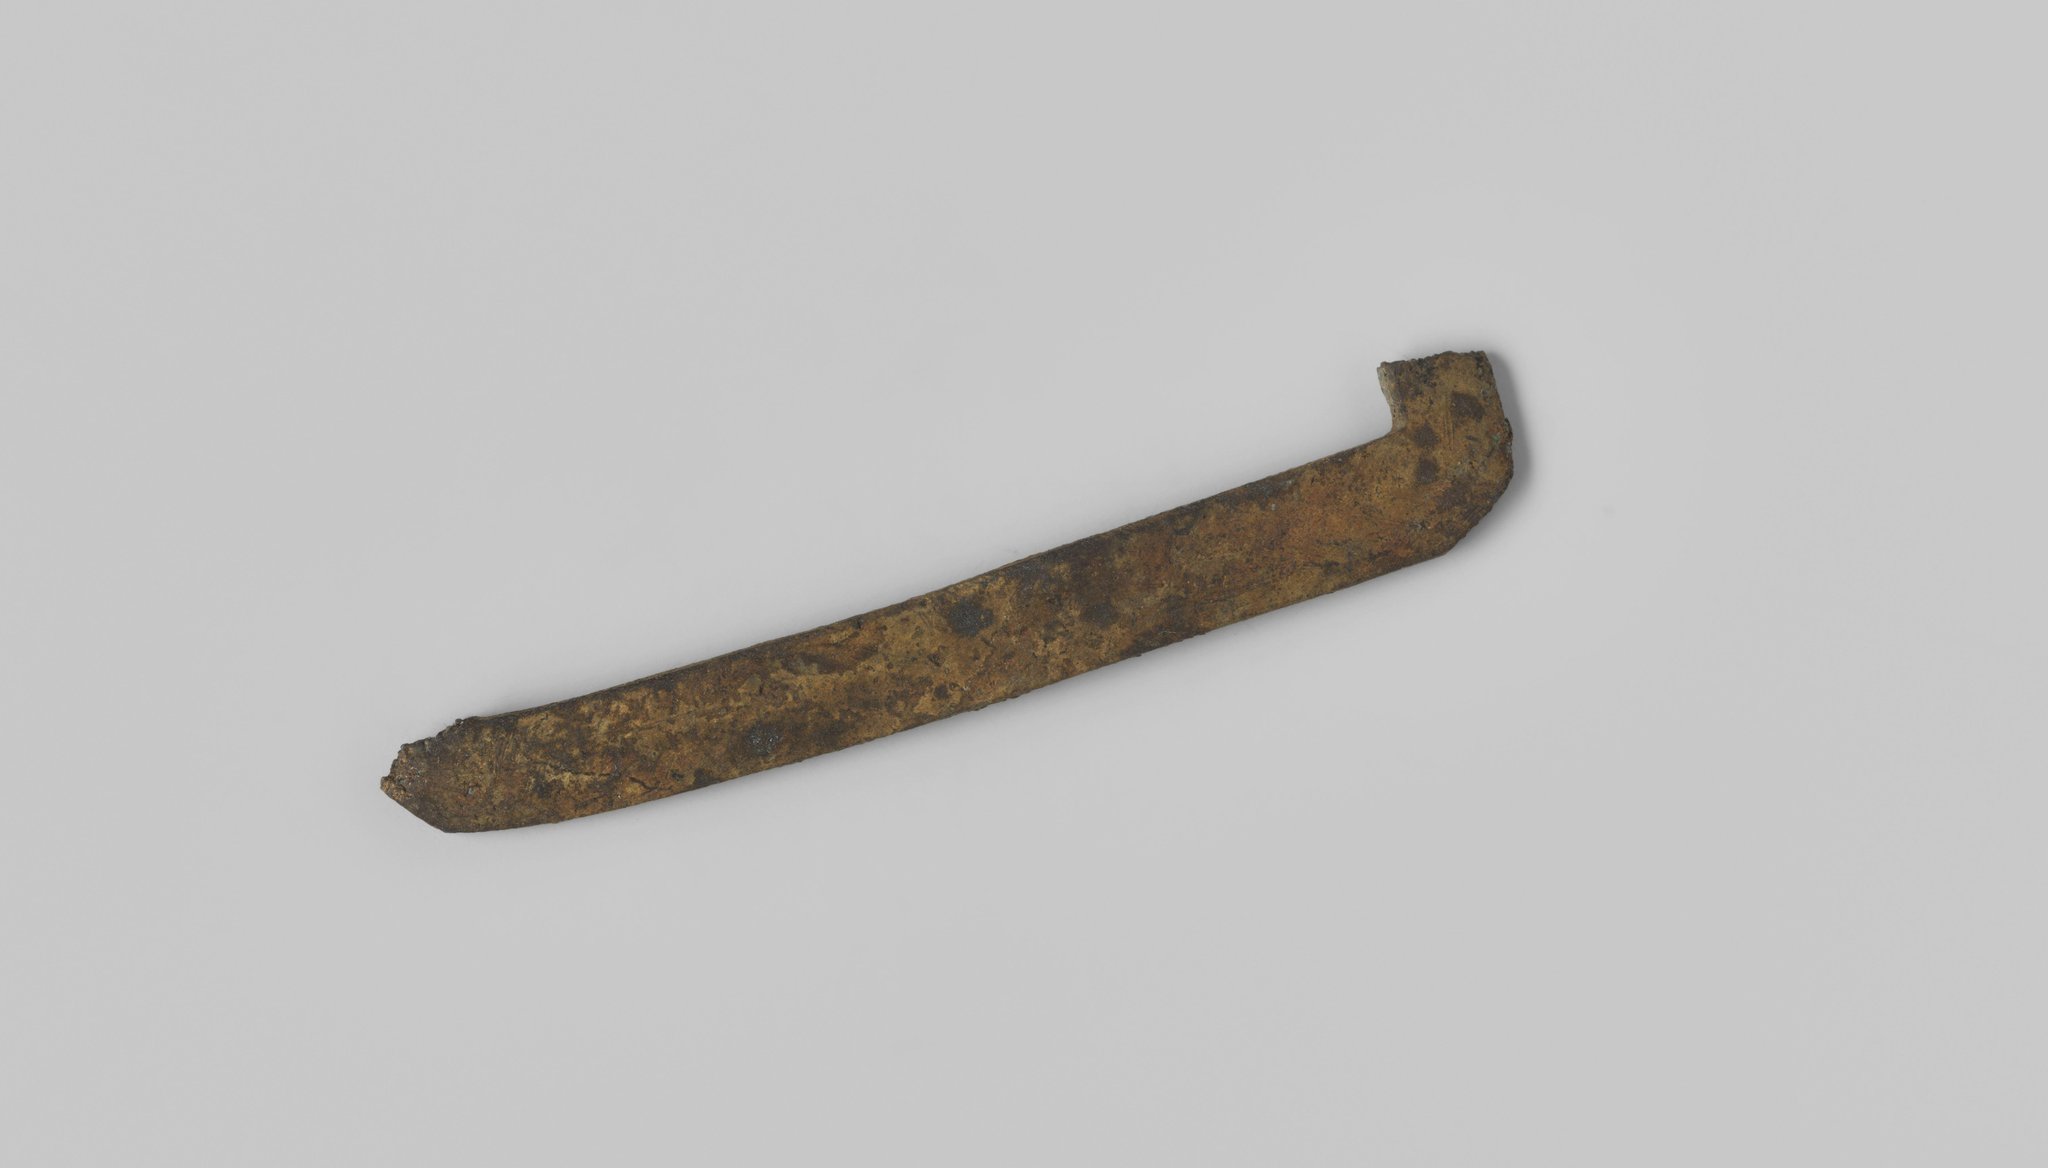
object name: belt buckle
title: Fragment riemgesp uit het wrak van de Oost-Indiëvaarder Hollandia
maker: Anonymous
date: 1700-1743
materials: copper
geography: netherlands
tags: verenigde oostindische compagnie, hollandia (schip), annet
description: Rectangular, fragm of ring, id. NG 1980-27H2796, belt buckle.